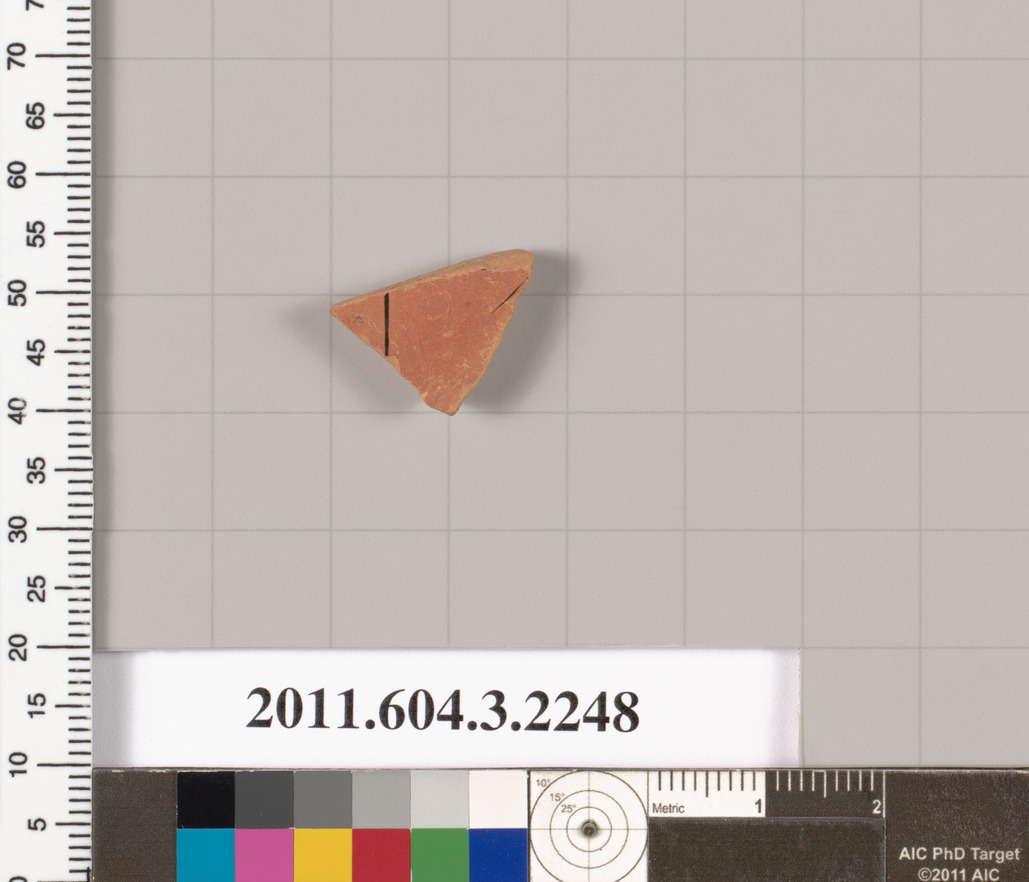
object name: kylix fragment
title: Terracotta fragment of a kylix (drinking cup)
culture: greek, attic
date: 600-401 BCE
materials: terracotta